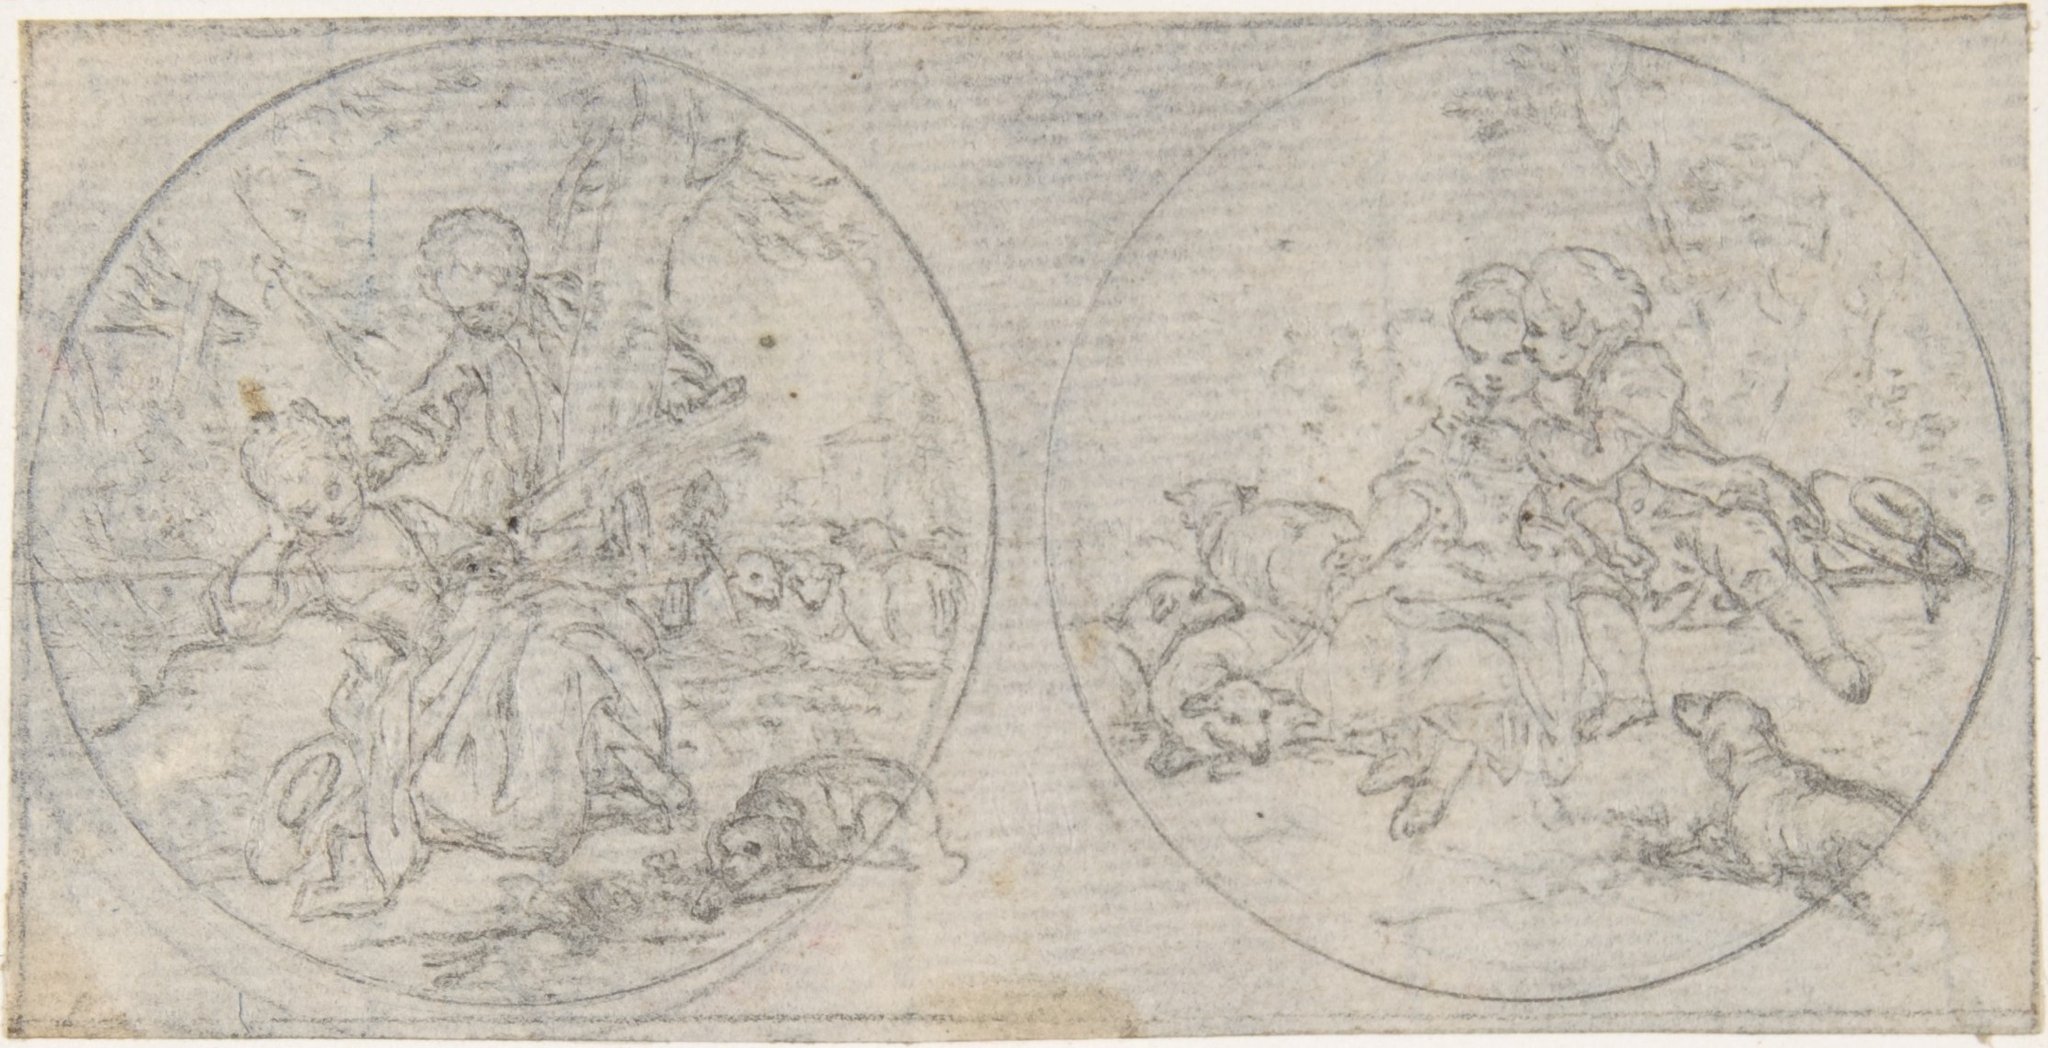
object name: drawing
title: Design for a Box-Lid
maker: hubert françois gravelot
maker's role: artist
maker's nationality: french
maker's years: 1699-1773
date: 1701-1800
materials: chalk, graphite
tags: boys,girls,dogs,trees